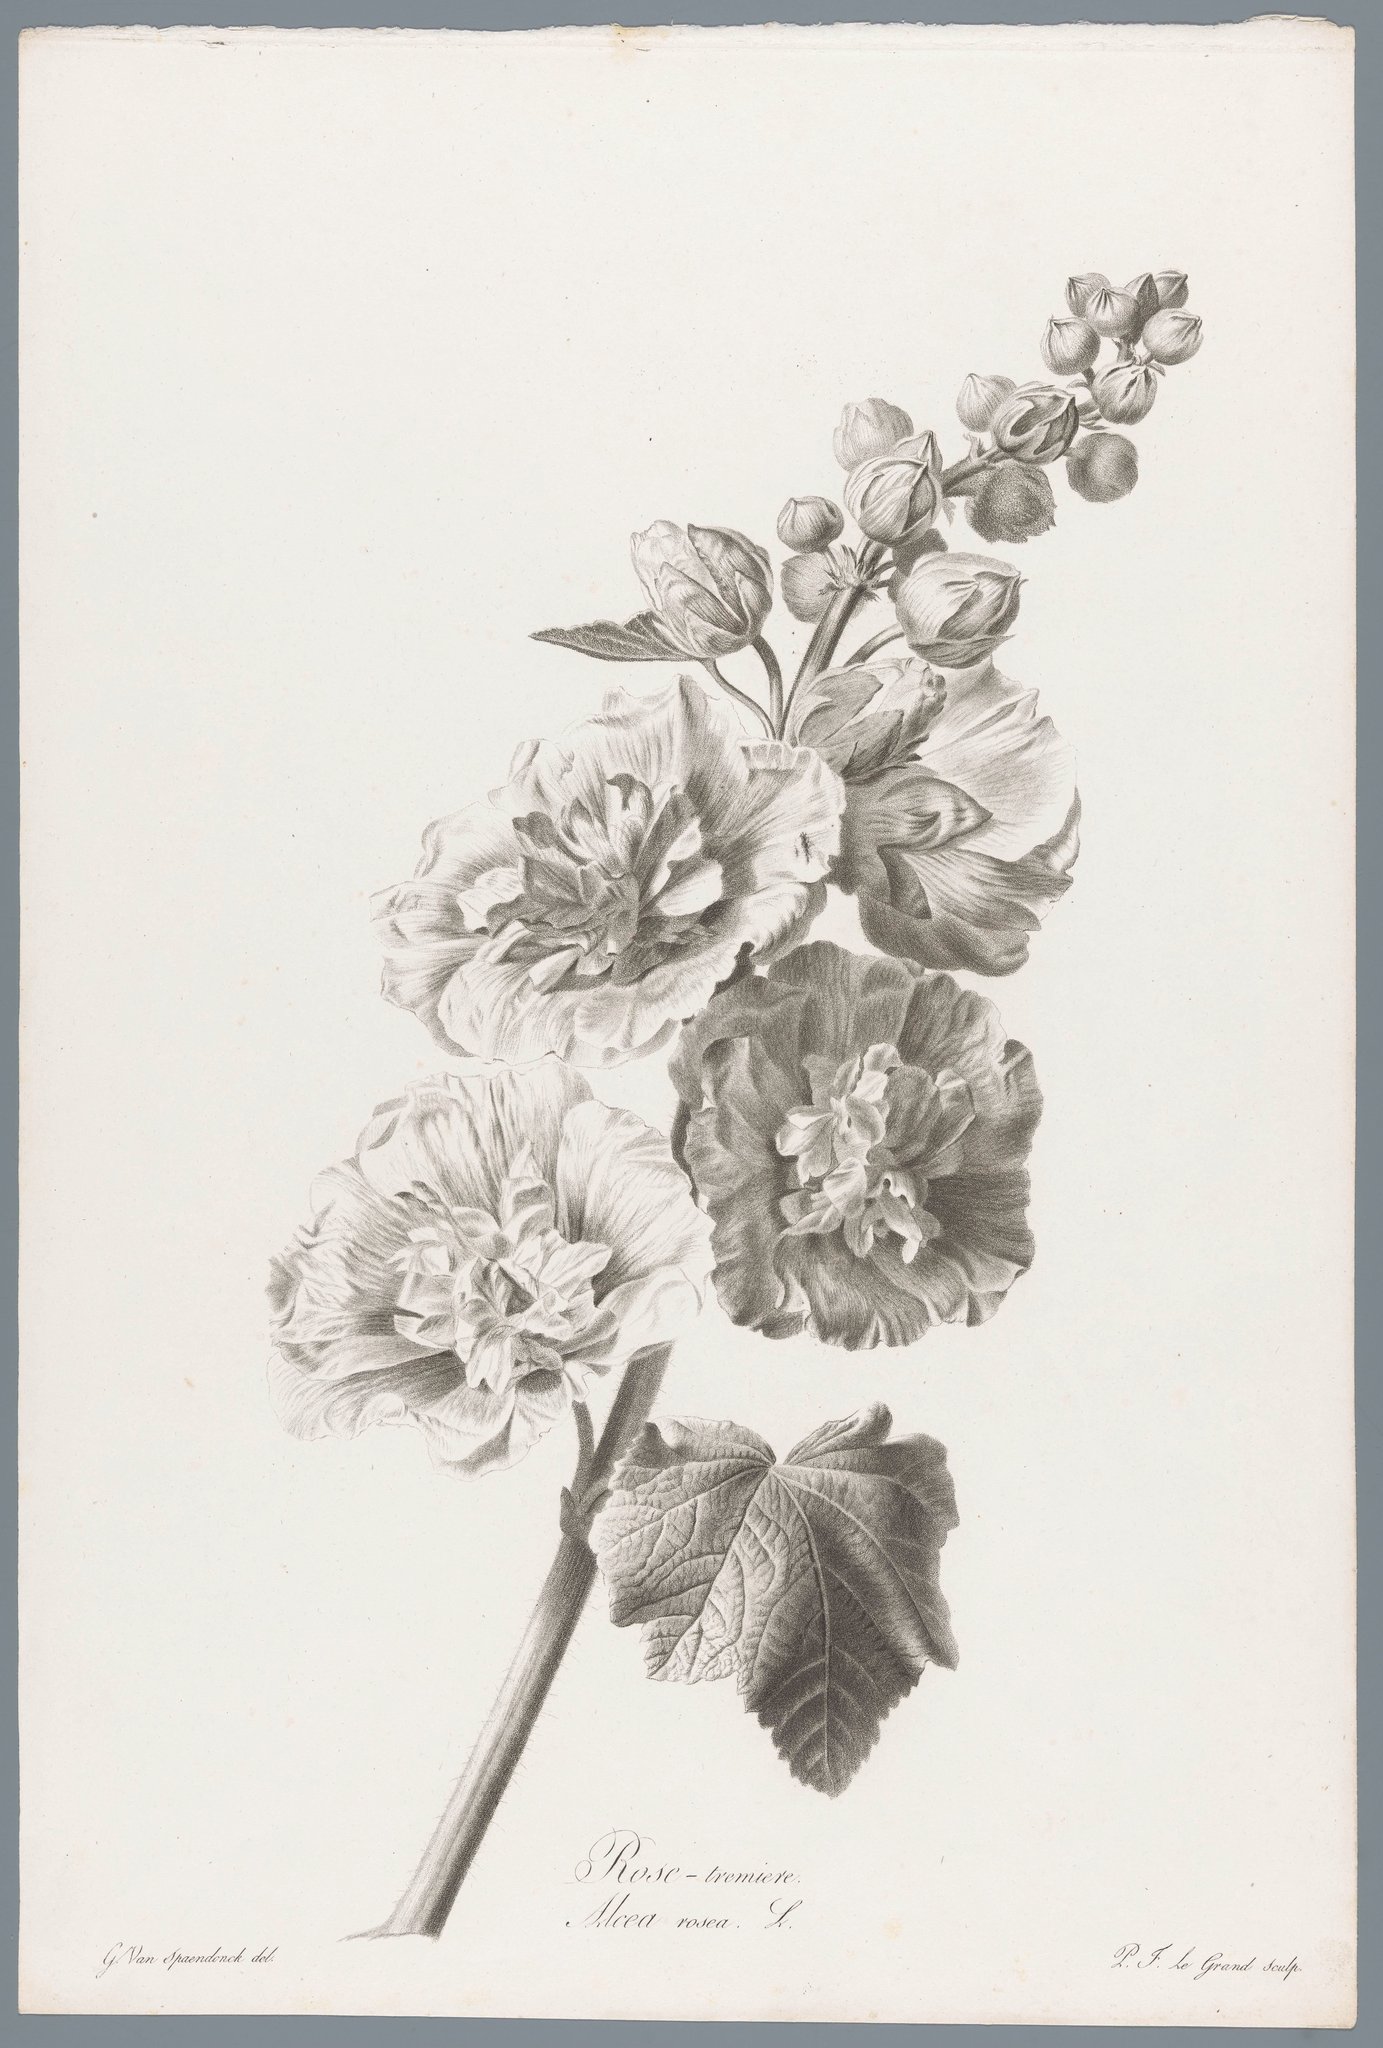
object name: ornament print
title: Fleurs dessinées d'après nature (...)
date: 1799-1801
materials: paper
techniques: engraving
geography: paris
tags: flowers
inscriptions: collector's mark: Lugt 2228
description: De serie Fleurs dessinées d'après nature (...) bestaat uit 24 prenten verdeeld over zes omslagen. Het Rijksprentenkabinet heeft 23 prenten in zes omslagen in bezit. De verdeling over de omslagen lijkt willekeurig. Zie RP-P-1909-4220 t/m 4242 en RP-P-2016-53 t/m 58.